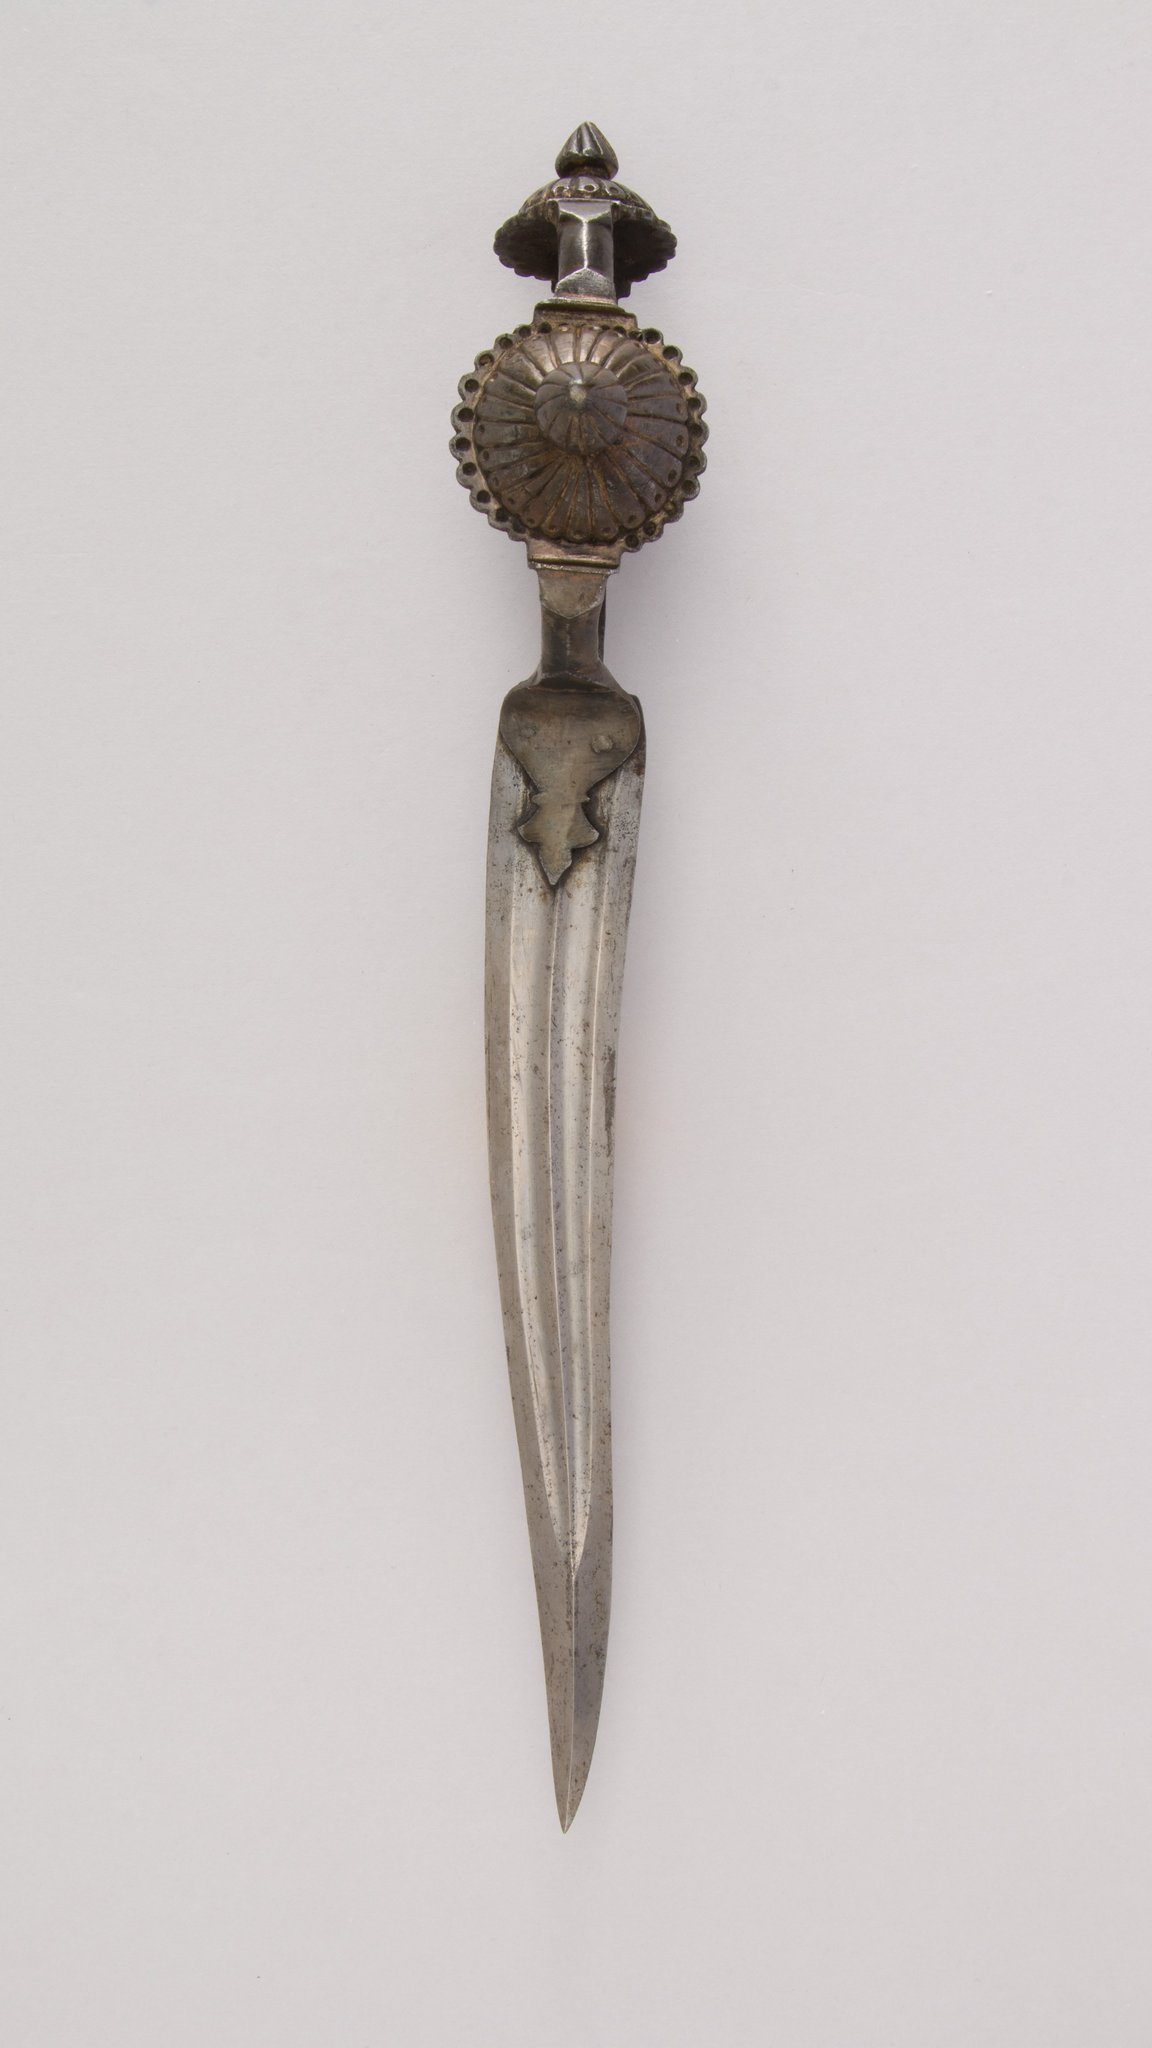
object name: dagger bichuwa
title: Dagger (Bichuwa)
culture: indian, south indian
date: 1701-1800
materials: silver, steel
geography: south india